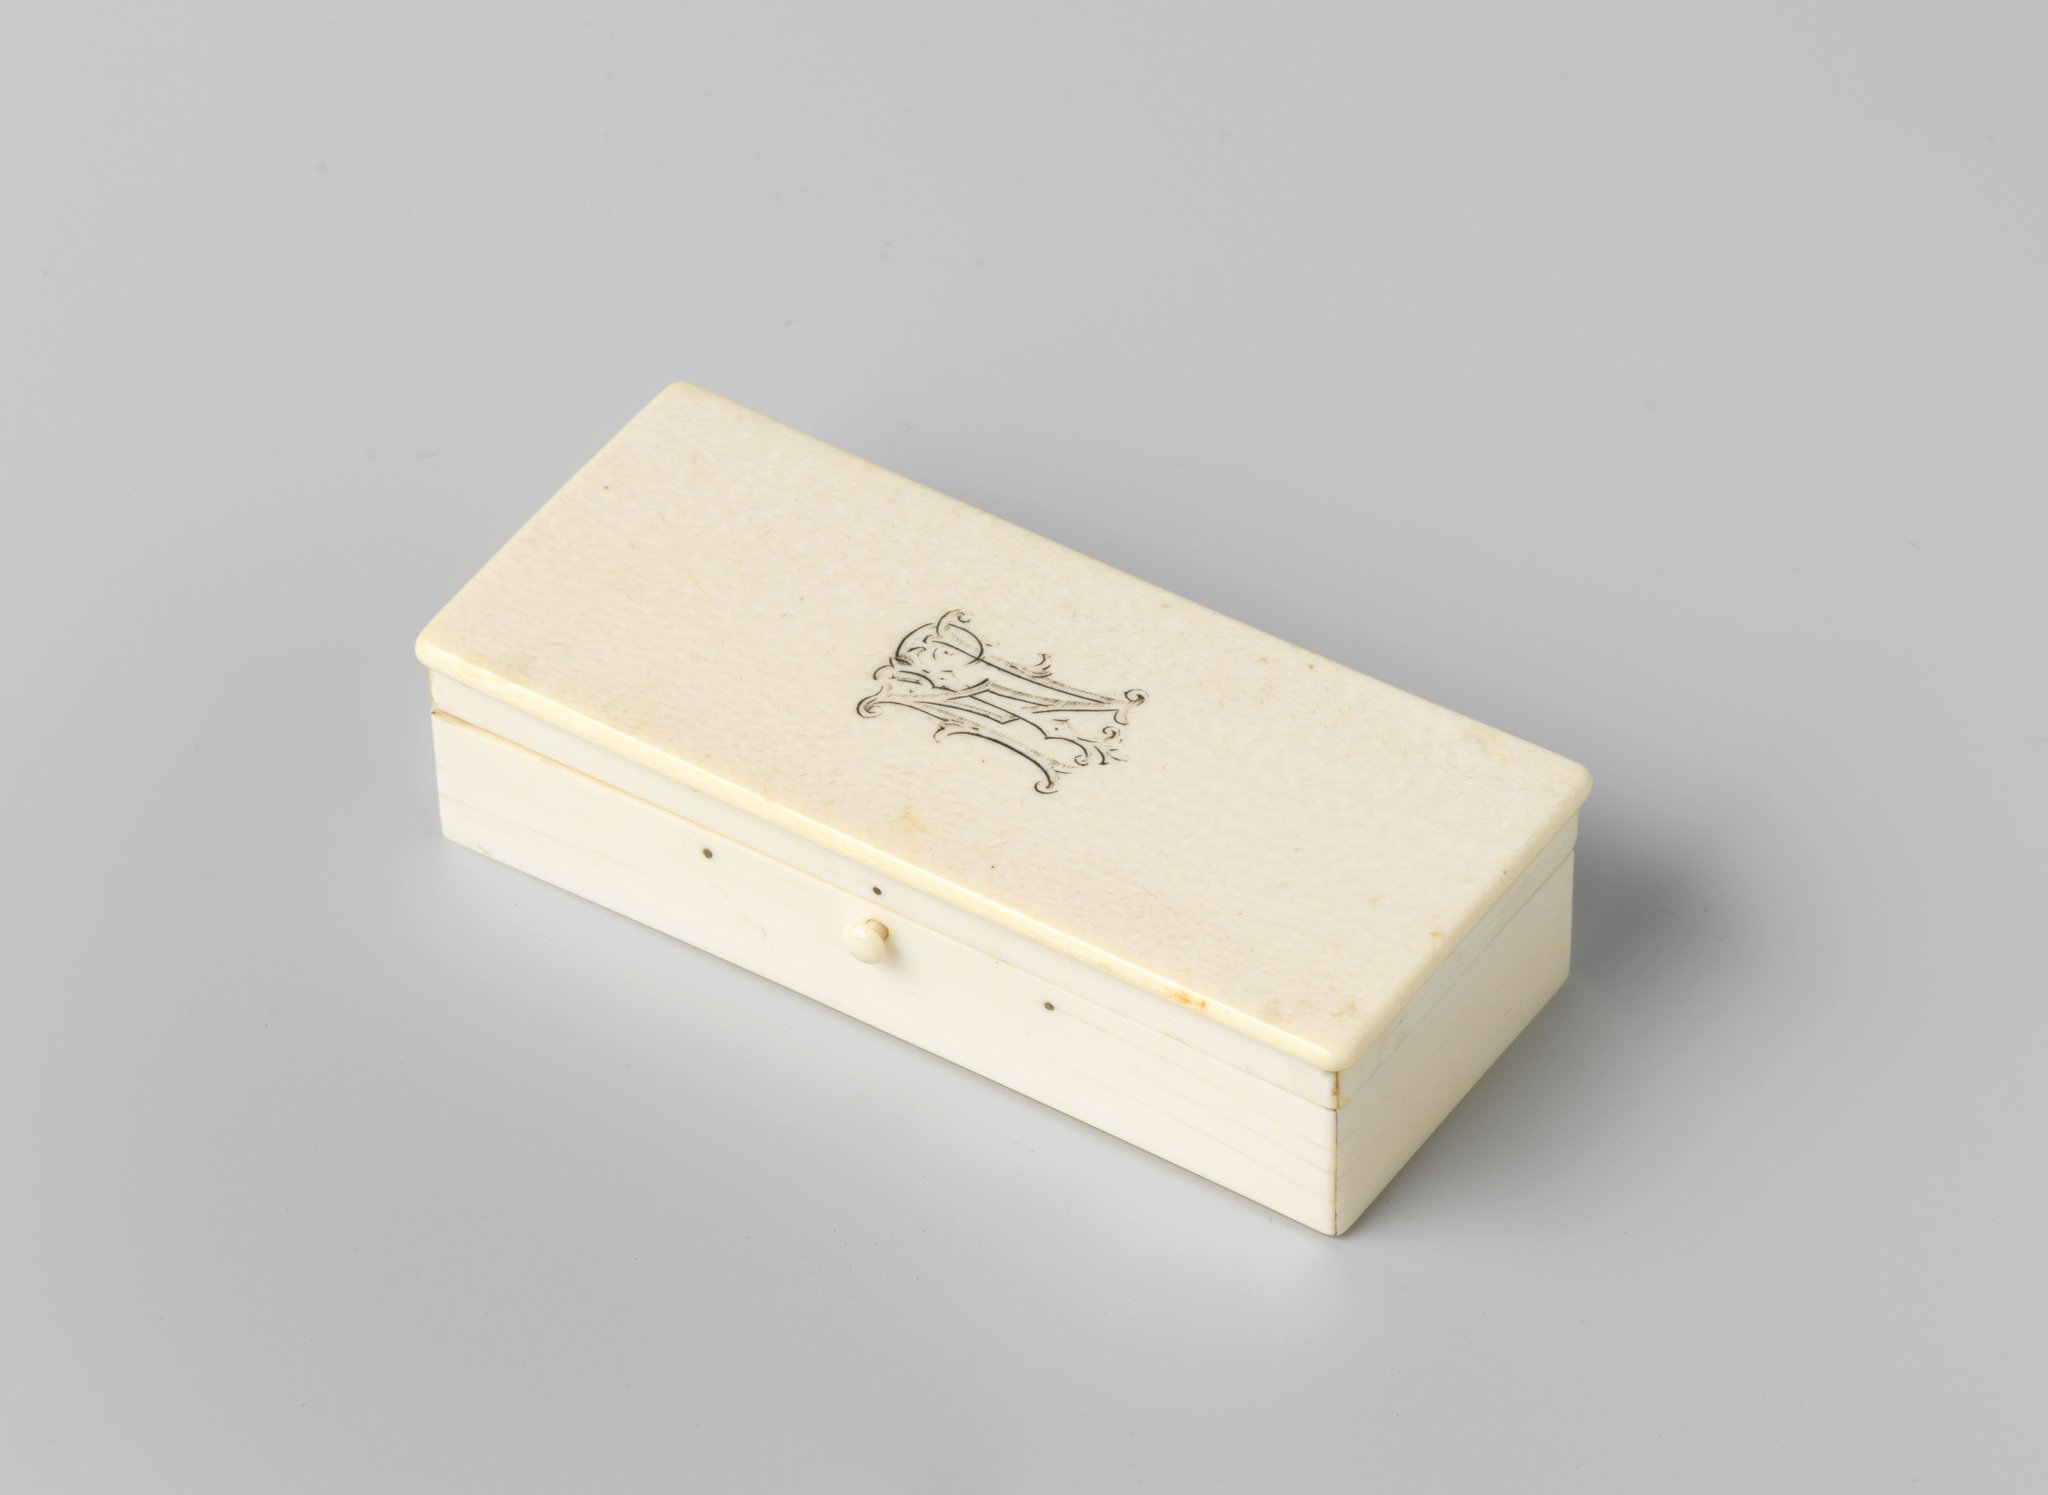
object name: toilet set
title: Doos, rechthoekig, van ivoor met monogram JVN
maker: Anonymous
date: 1910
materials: iron, ivory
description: Doos, rechthoekig, van ivoor met monogram JVN, in geborduurd zakje.